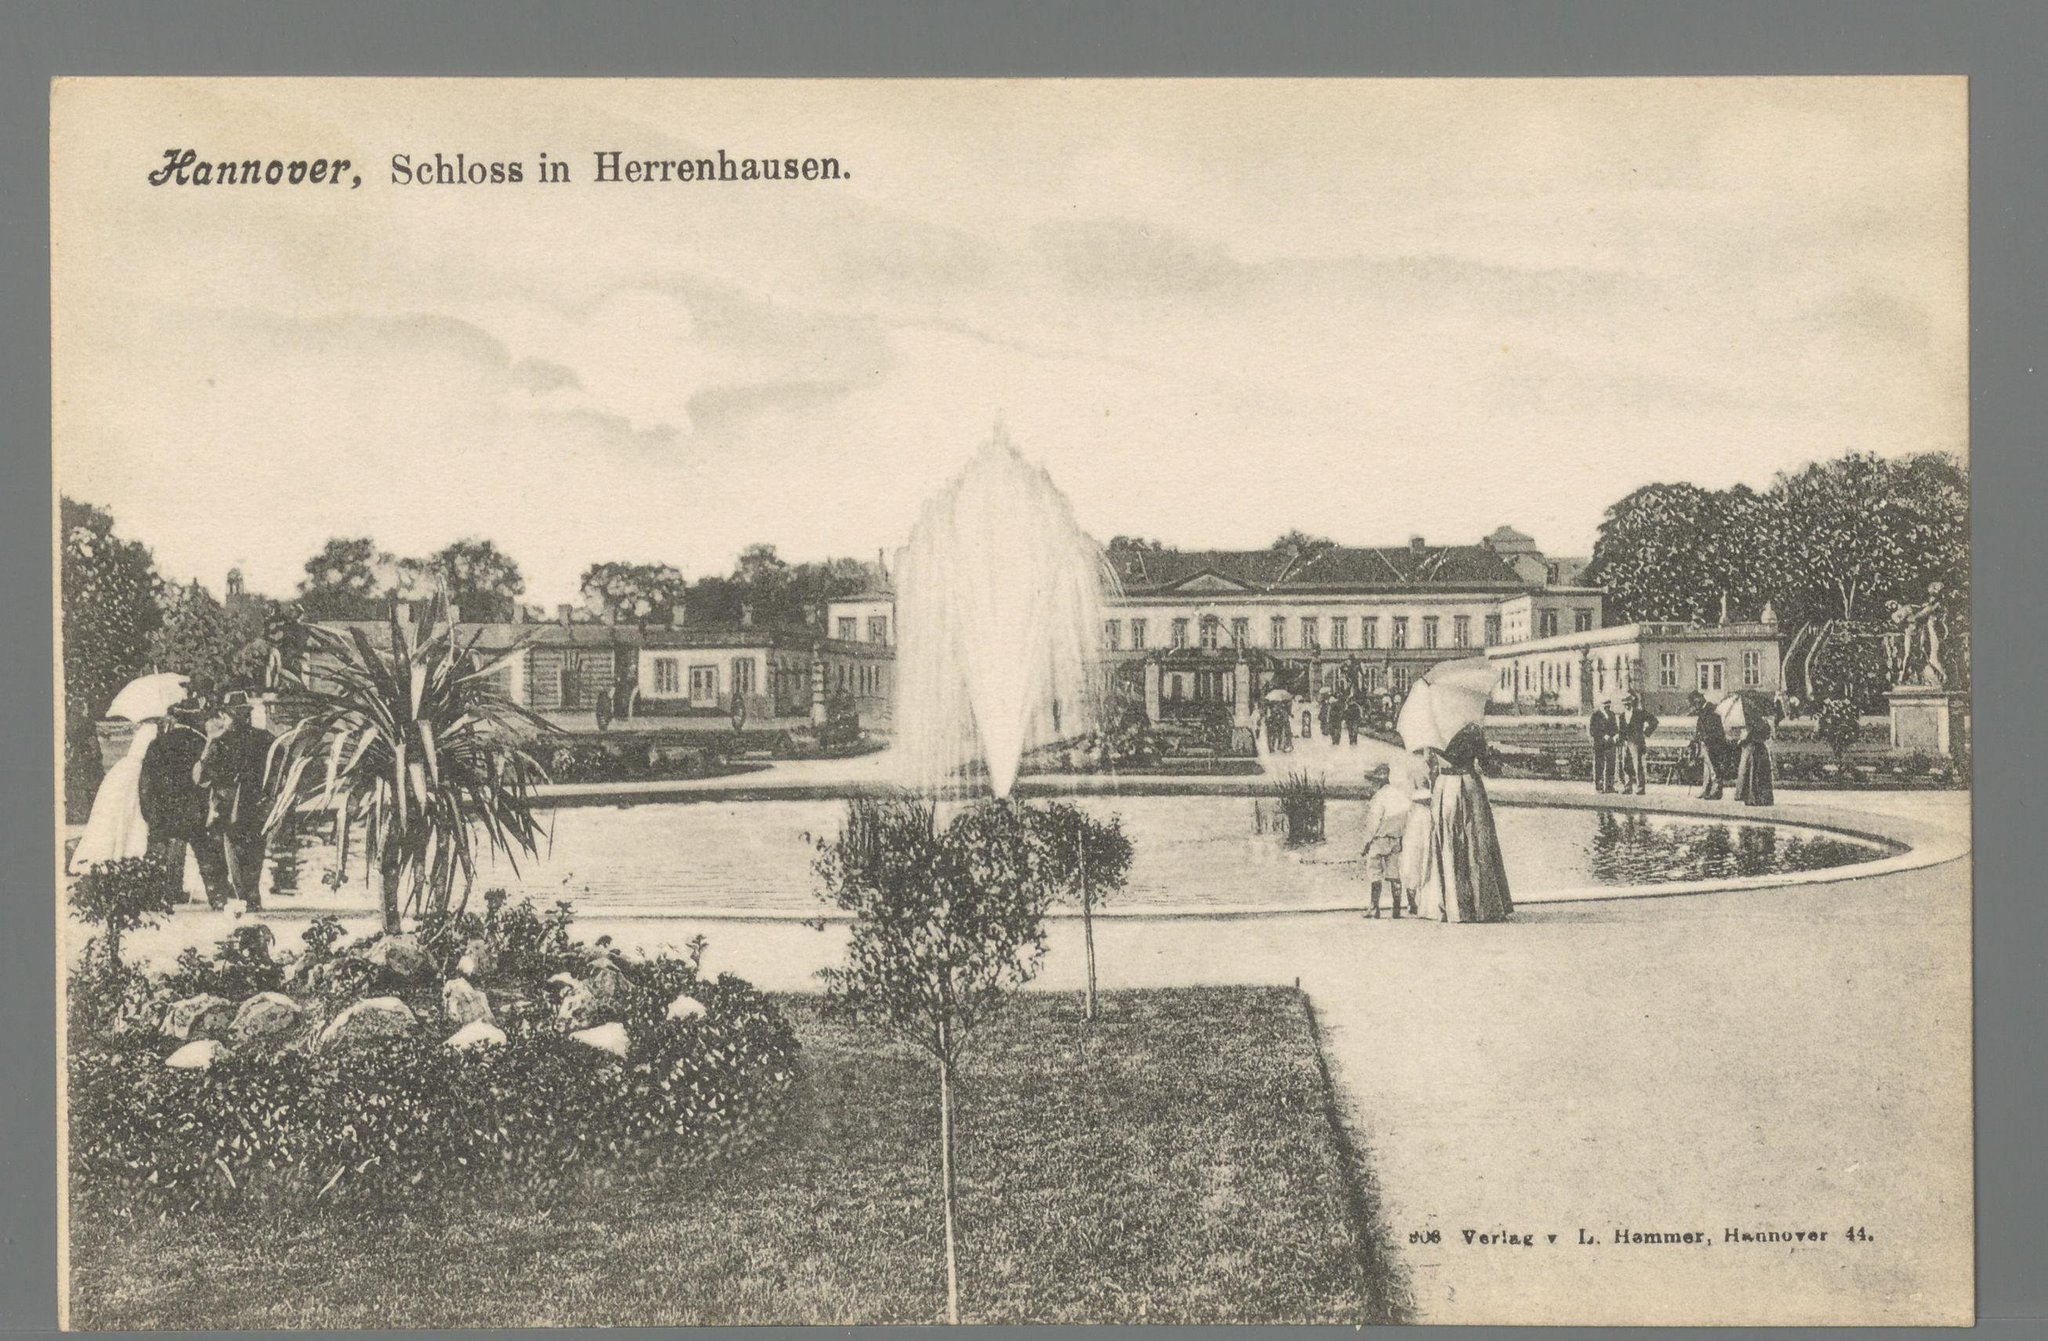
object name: photomechanical print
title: Hannover, Schloss in Herrenhausen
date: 1906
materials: cardboard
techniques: photograph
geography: hannover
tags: castle, ornamental fountain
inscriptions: date